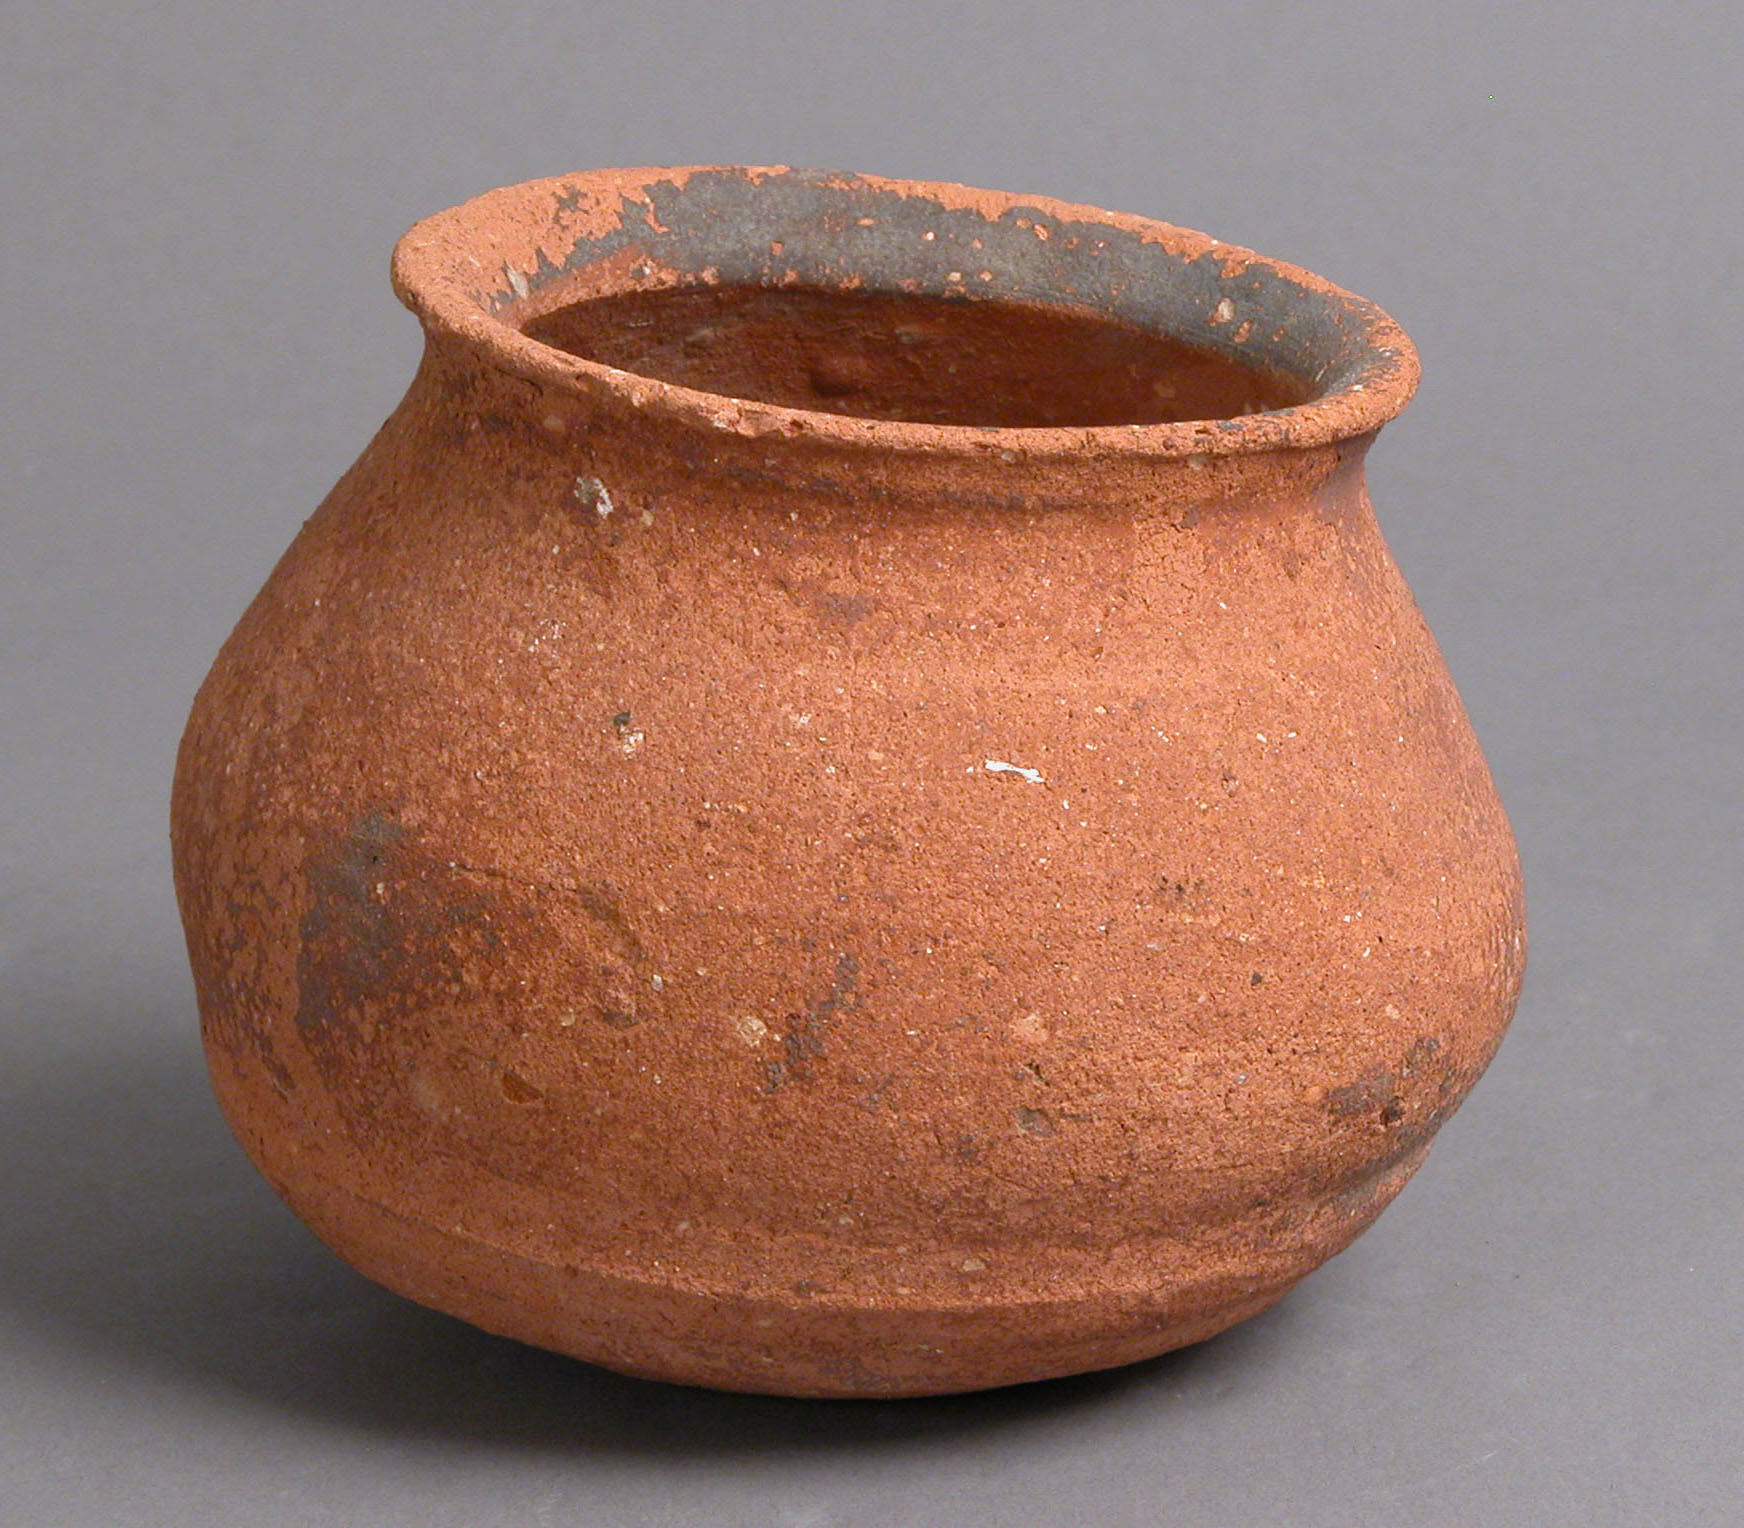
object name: pot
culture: coptic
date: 301-700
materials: earthenware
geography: egypt